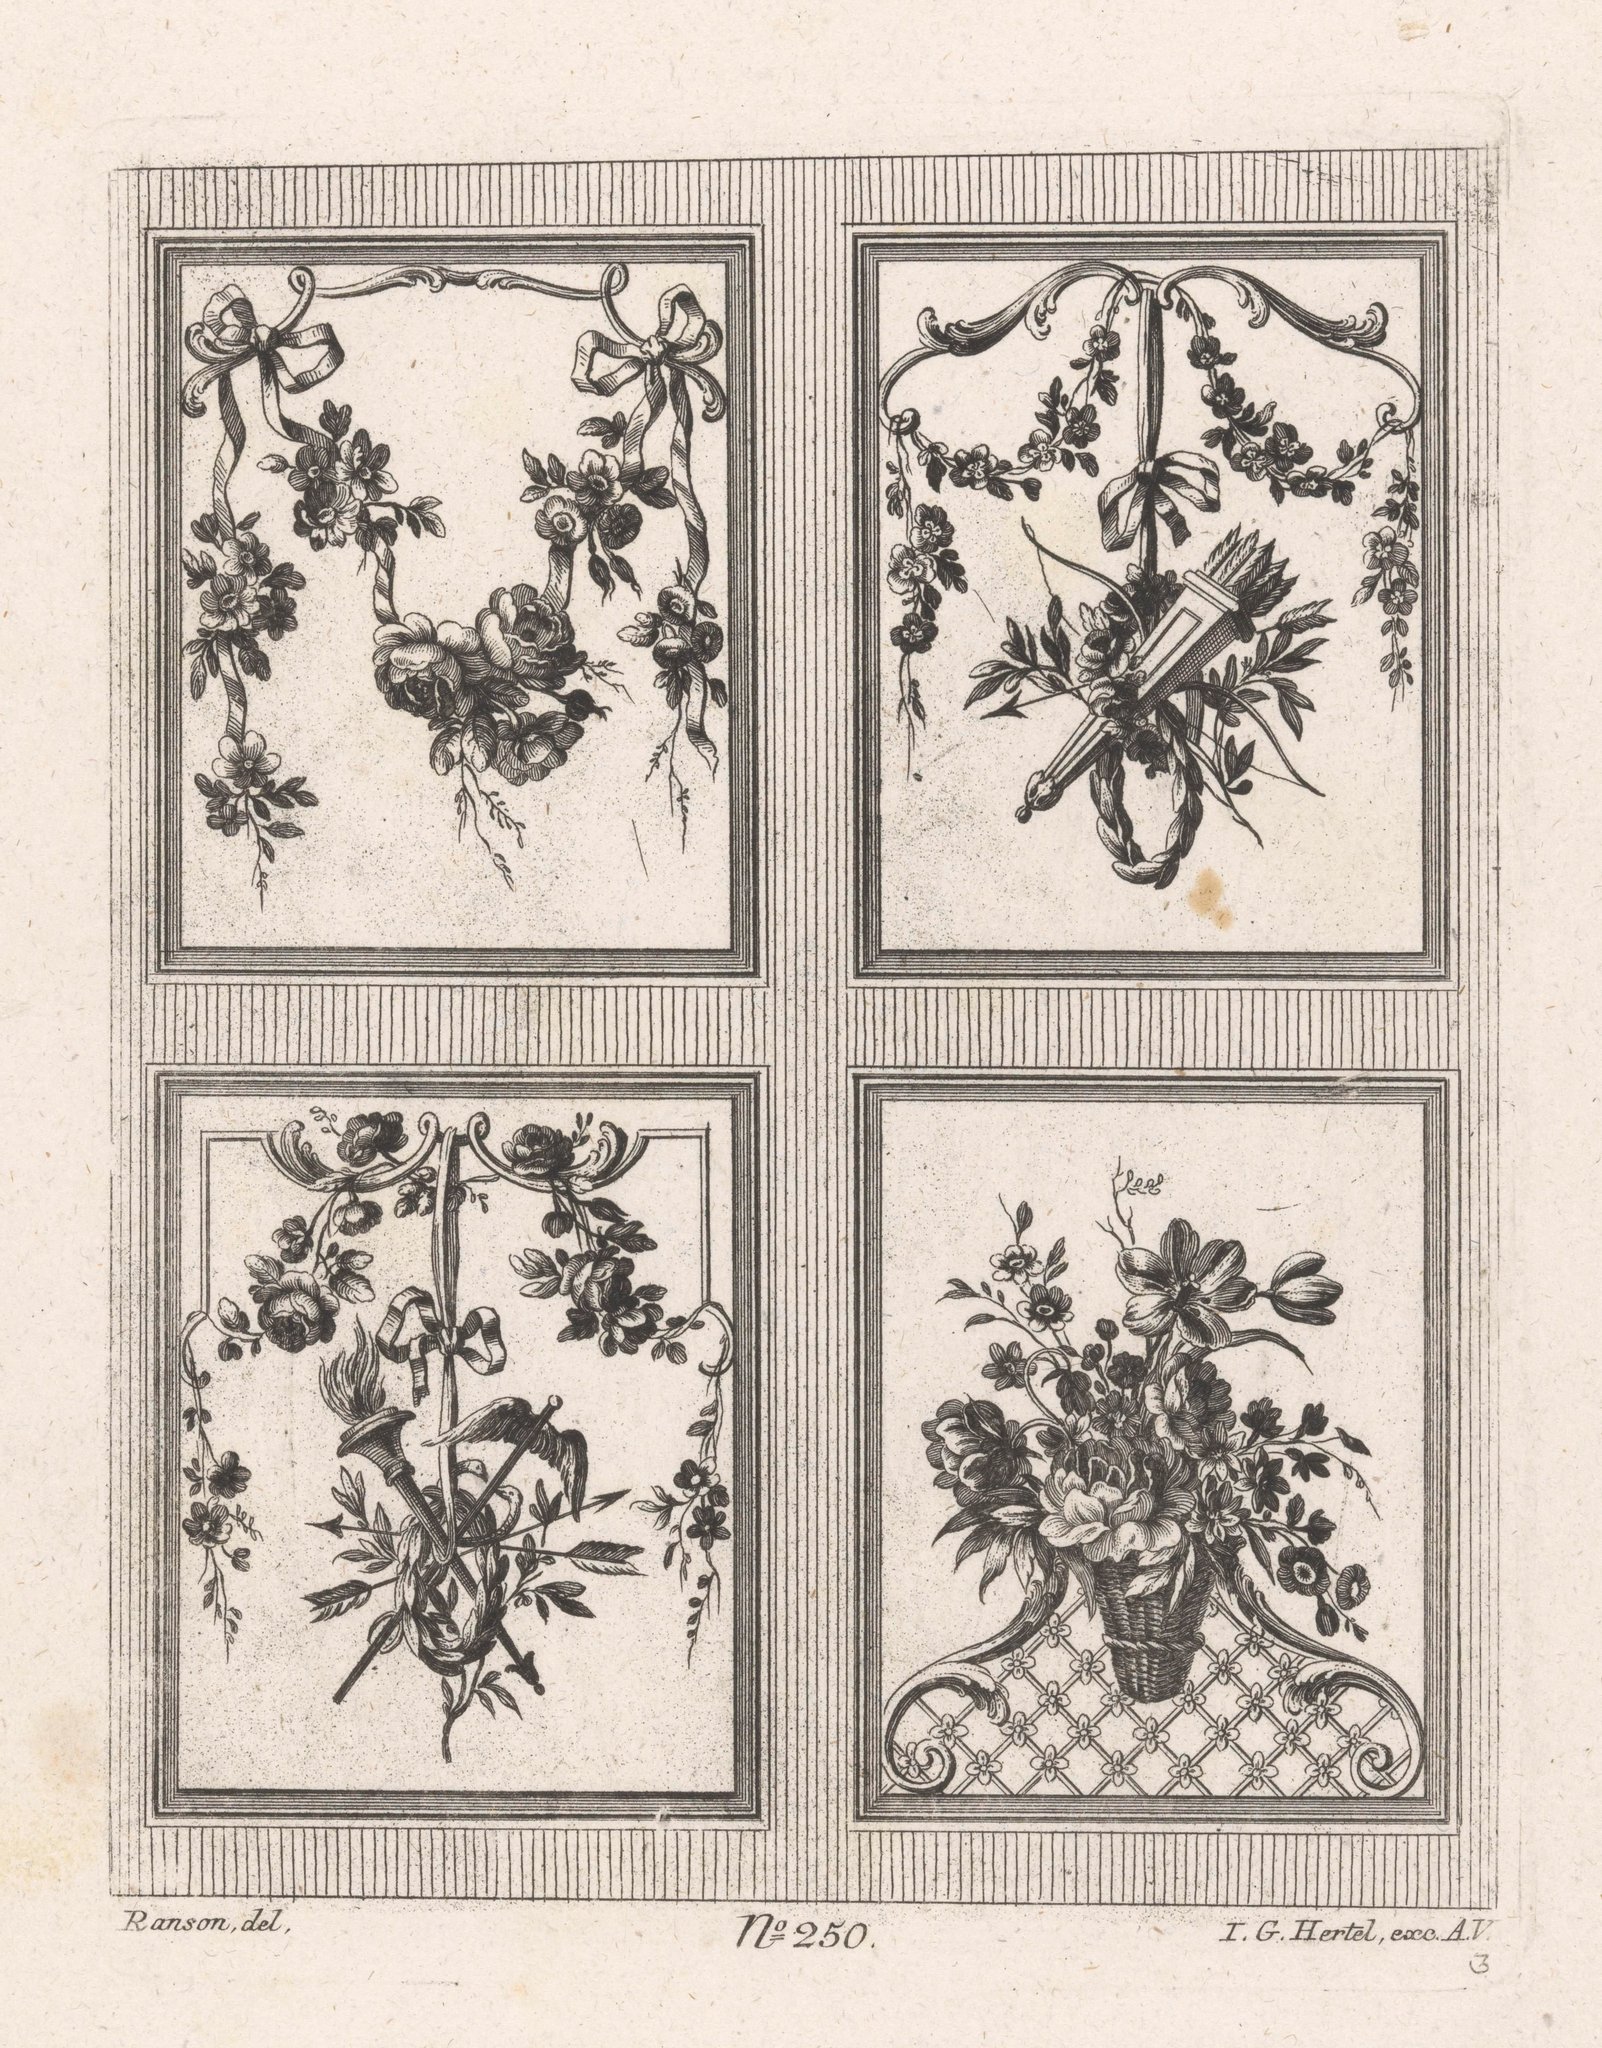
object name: ornament print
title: Guirlande, trofeeën en vaas met bloemen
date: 1746-1775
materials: paper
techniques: etching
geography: augsburg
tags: trophy, i.e.: decorative arrangement of symbolic or typical objects ~ ornament, flowers in a vase, ornament ~ festoon, garland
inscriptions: collector's mark: Lugt 2228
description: Links boven een guirlande met bloemen en strikken. Rechts boven een trofee met guirlandes, pijlenkoker, pijl en boog. Links onder een trofee met guirlandes, pijlen, fakkel en caduceus. Rechts onder een vaas met bloemen, aan de onderzijde rocailles en bloemmotieven. Uitgeversnummer 250.